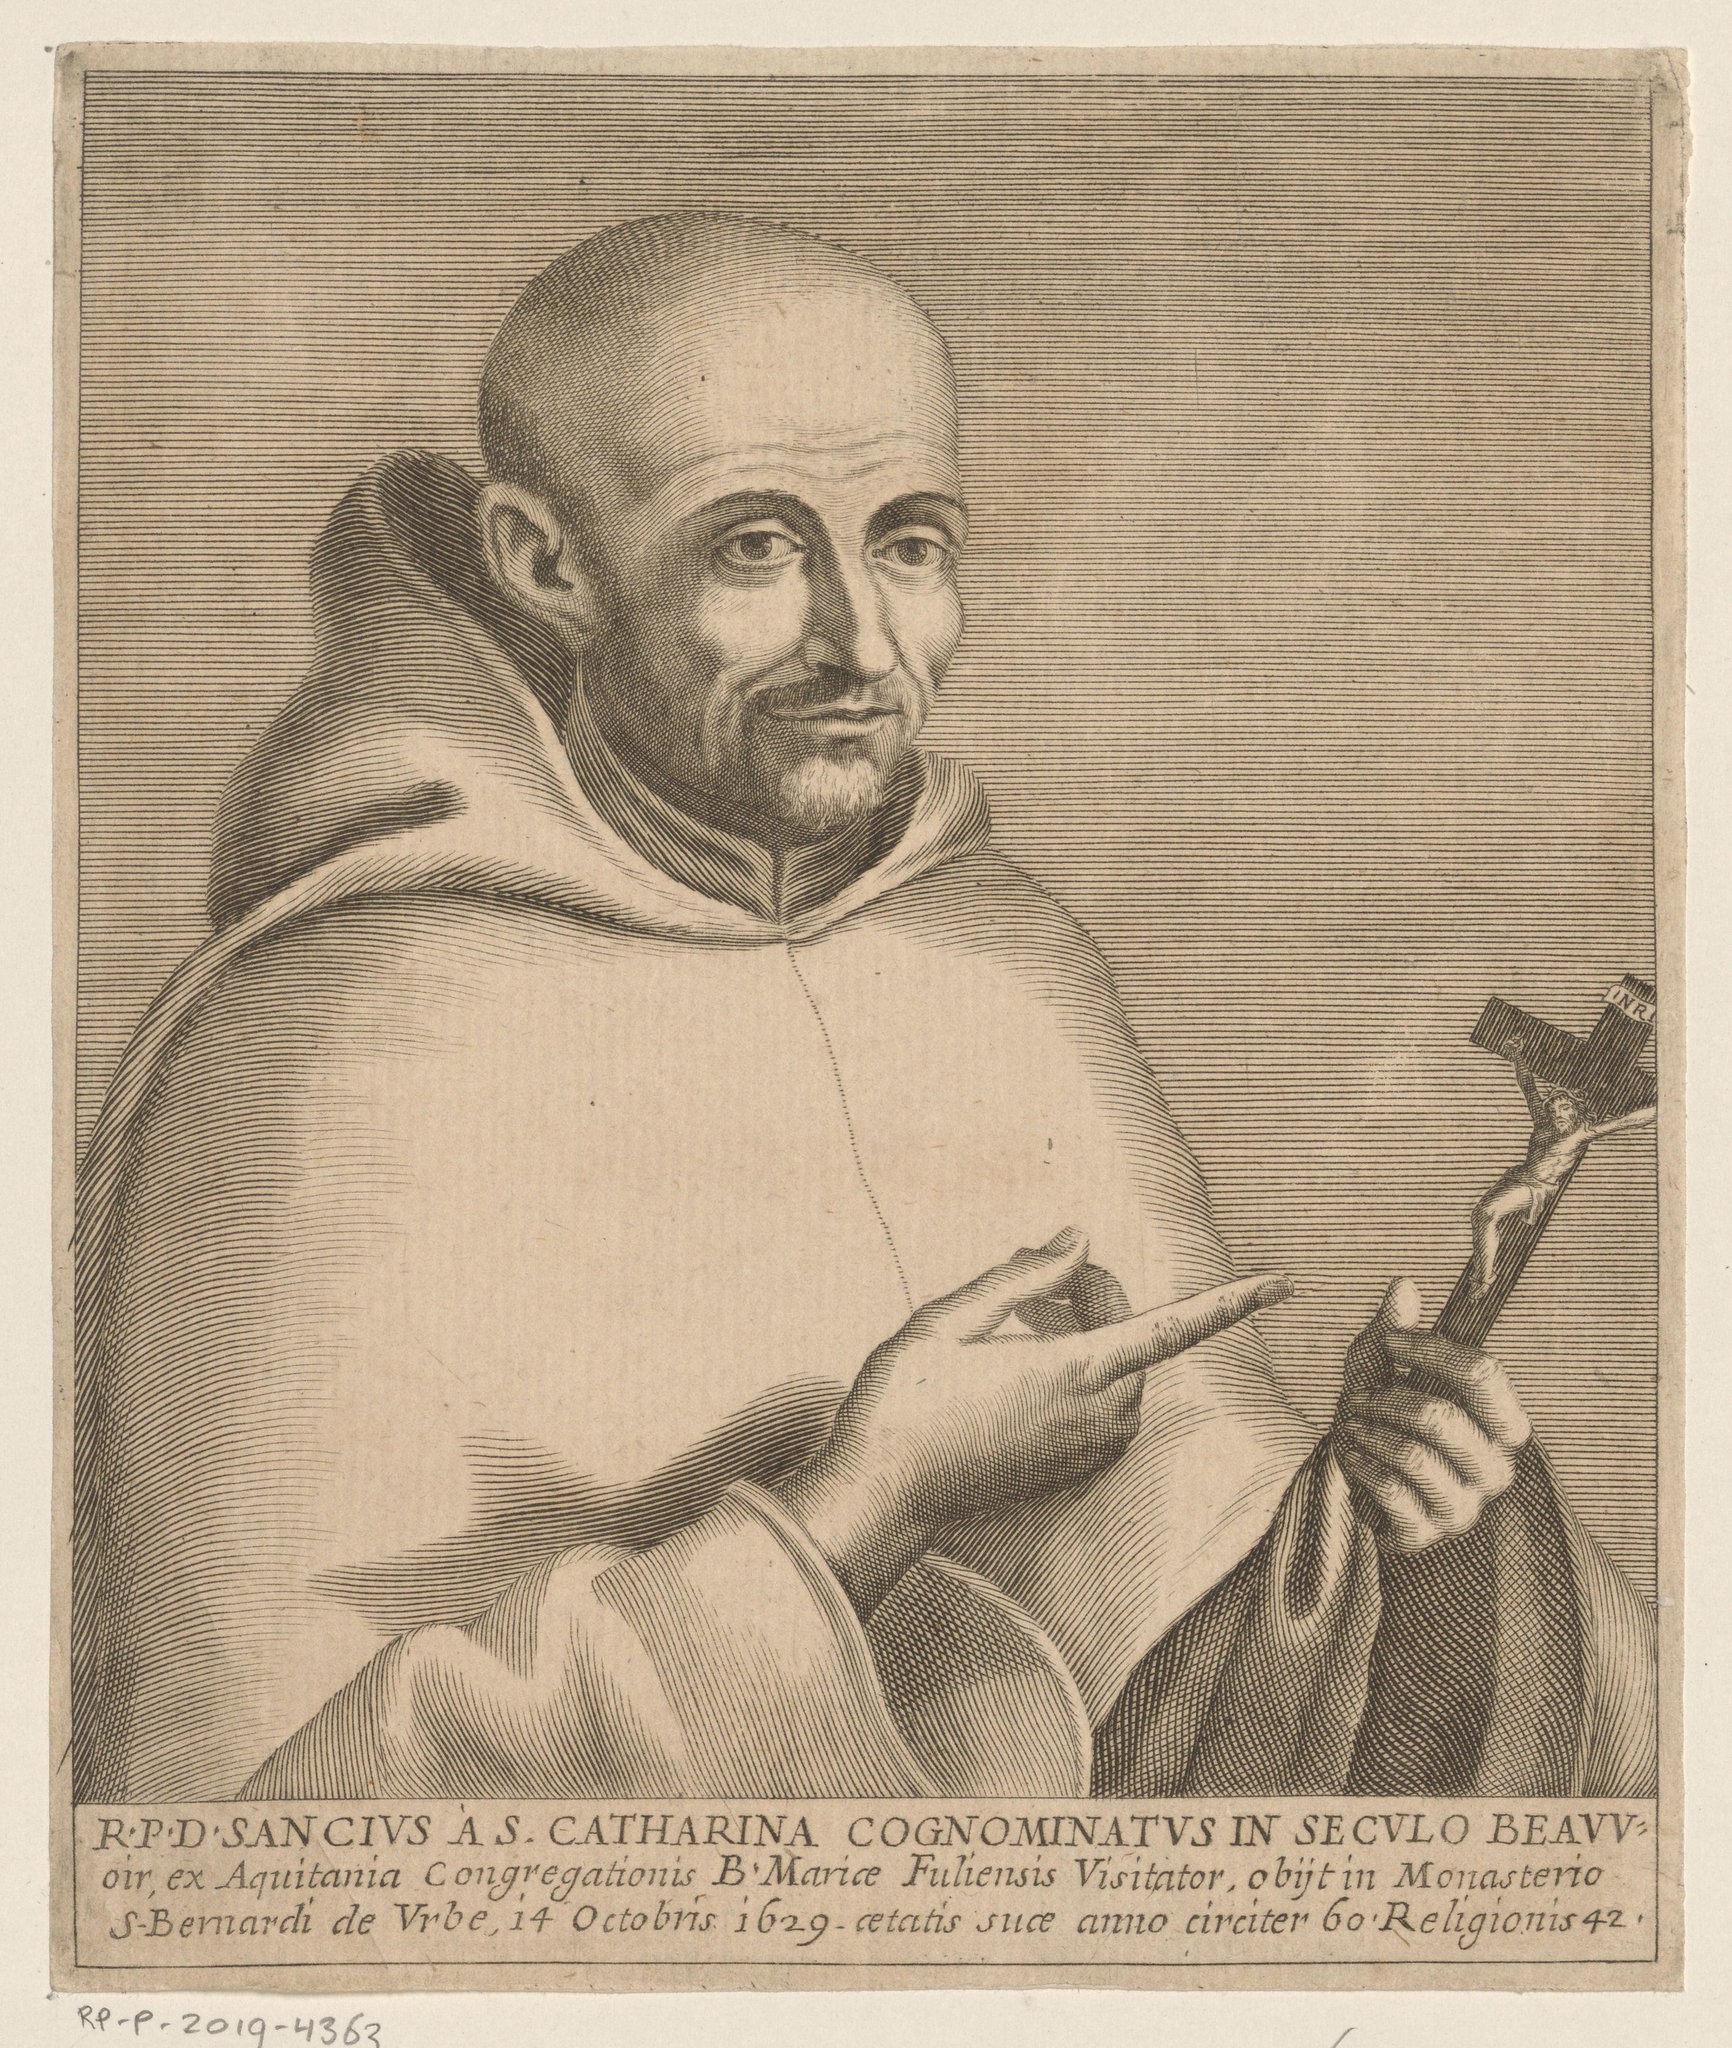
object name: print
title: Portret van de monnik Beauvoir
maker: Anonymous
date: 1629-1649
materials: paper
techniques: engraving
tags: historical persons, monk(s), friar(s), crucifix ~ personal devotion